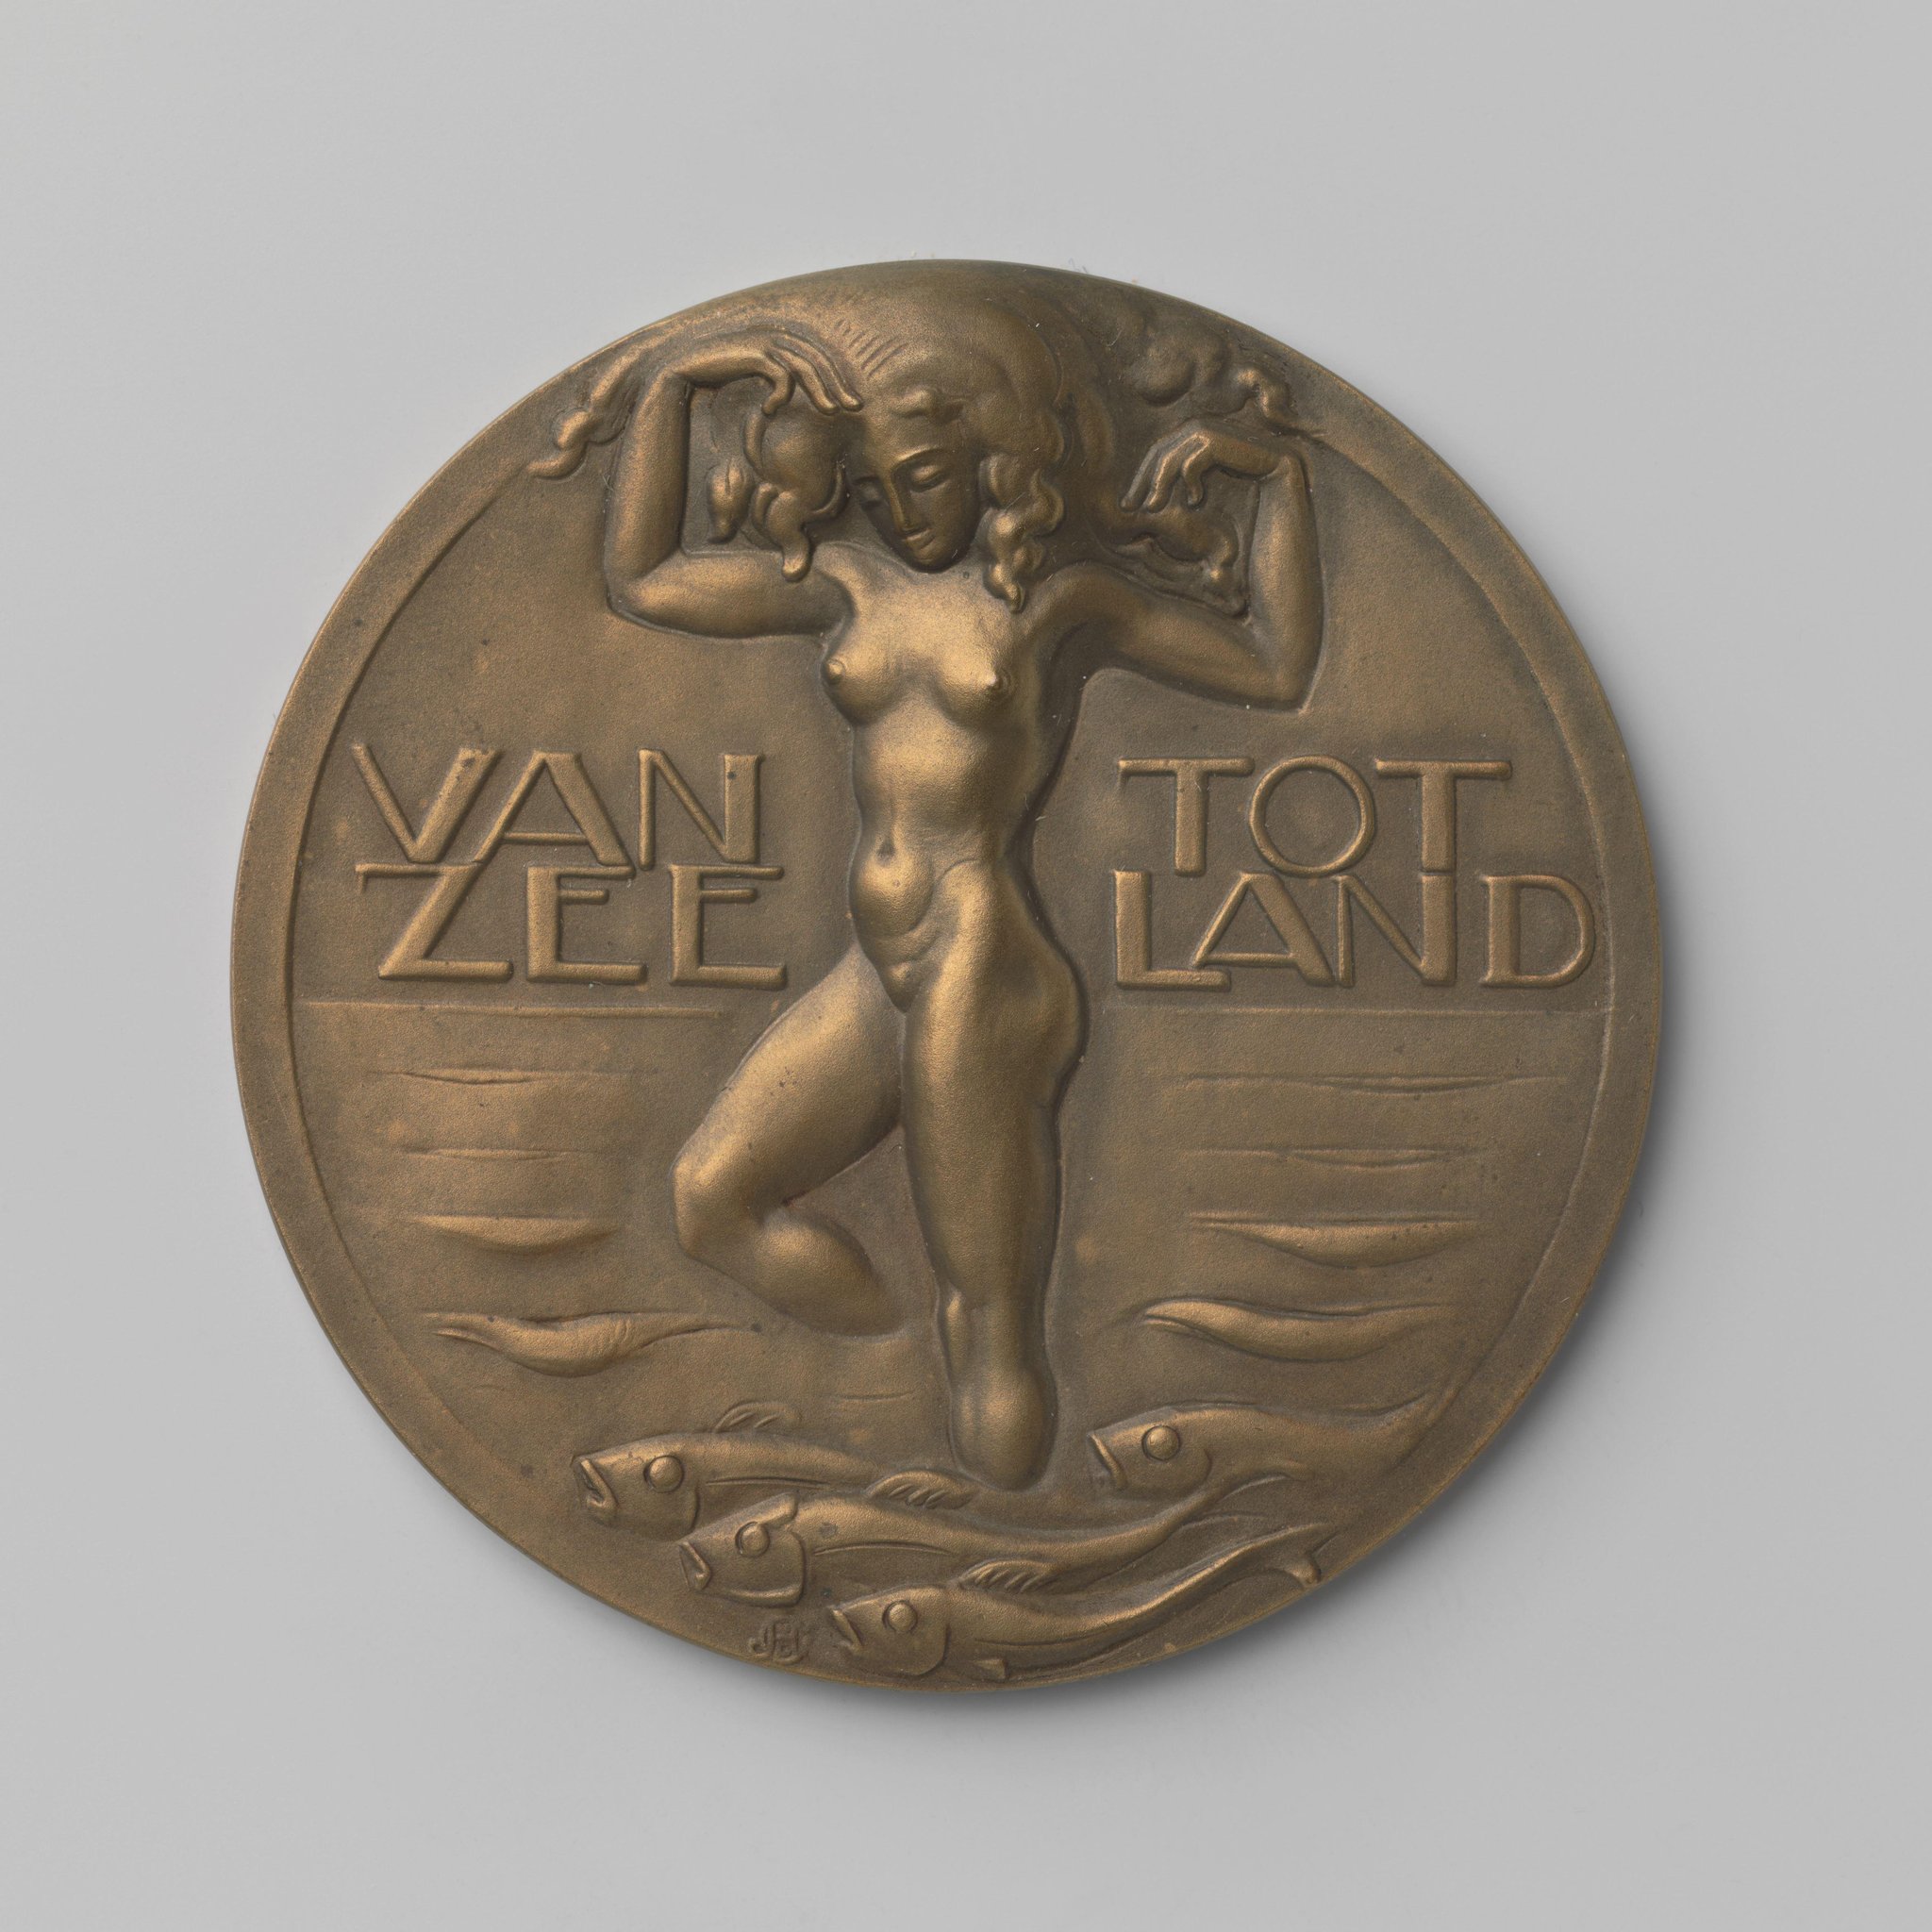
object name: history medal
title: Droogmaking van de Zuiderzee (Vereniging voor Penningkunst 1930, tweede penning)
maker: gijsbert jacobs van den hof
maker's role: sculptor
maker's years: 1889-1965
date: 1930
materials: bronze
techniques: striking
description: Bronzen penning, op de voorzijde een vrouw die te midden van vissen oprijst uit zee, in het veld twee regels tekst, op de keerzijde de landkaart van de toekomstige Zuiderzeepolders, met verklaring.